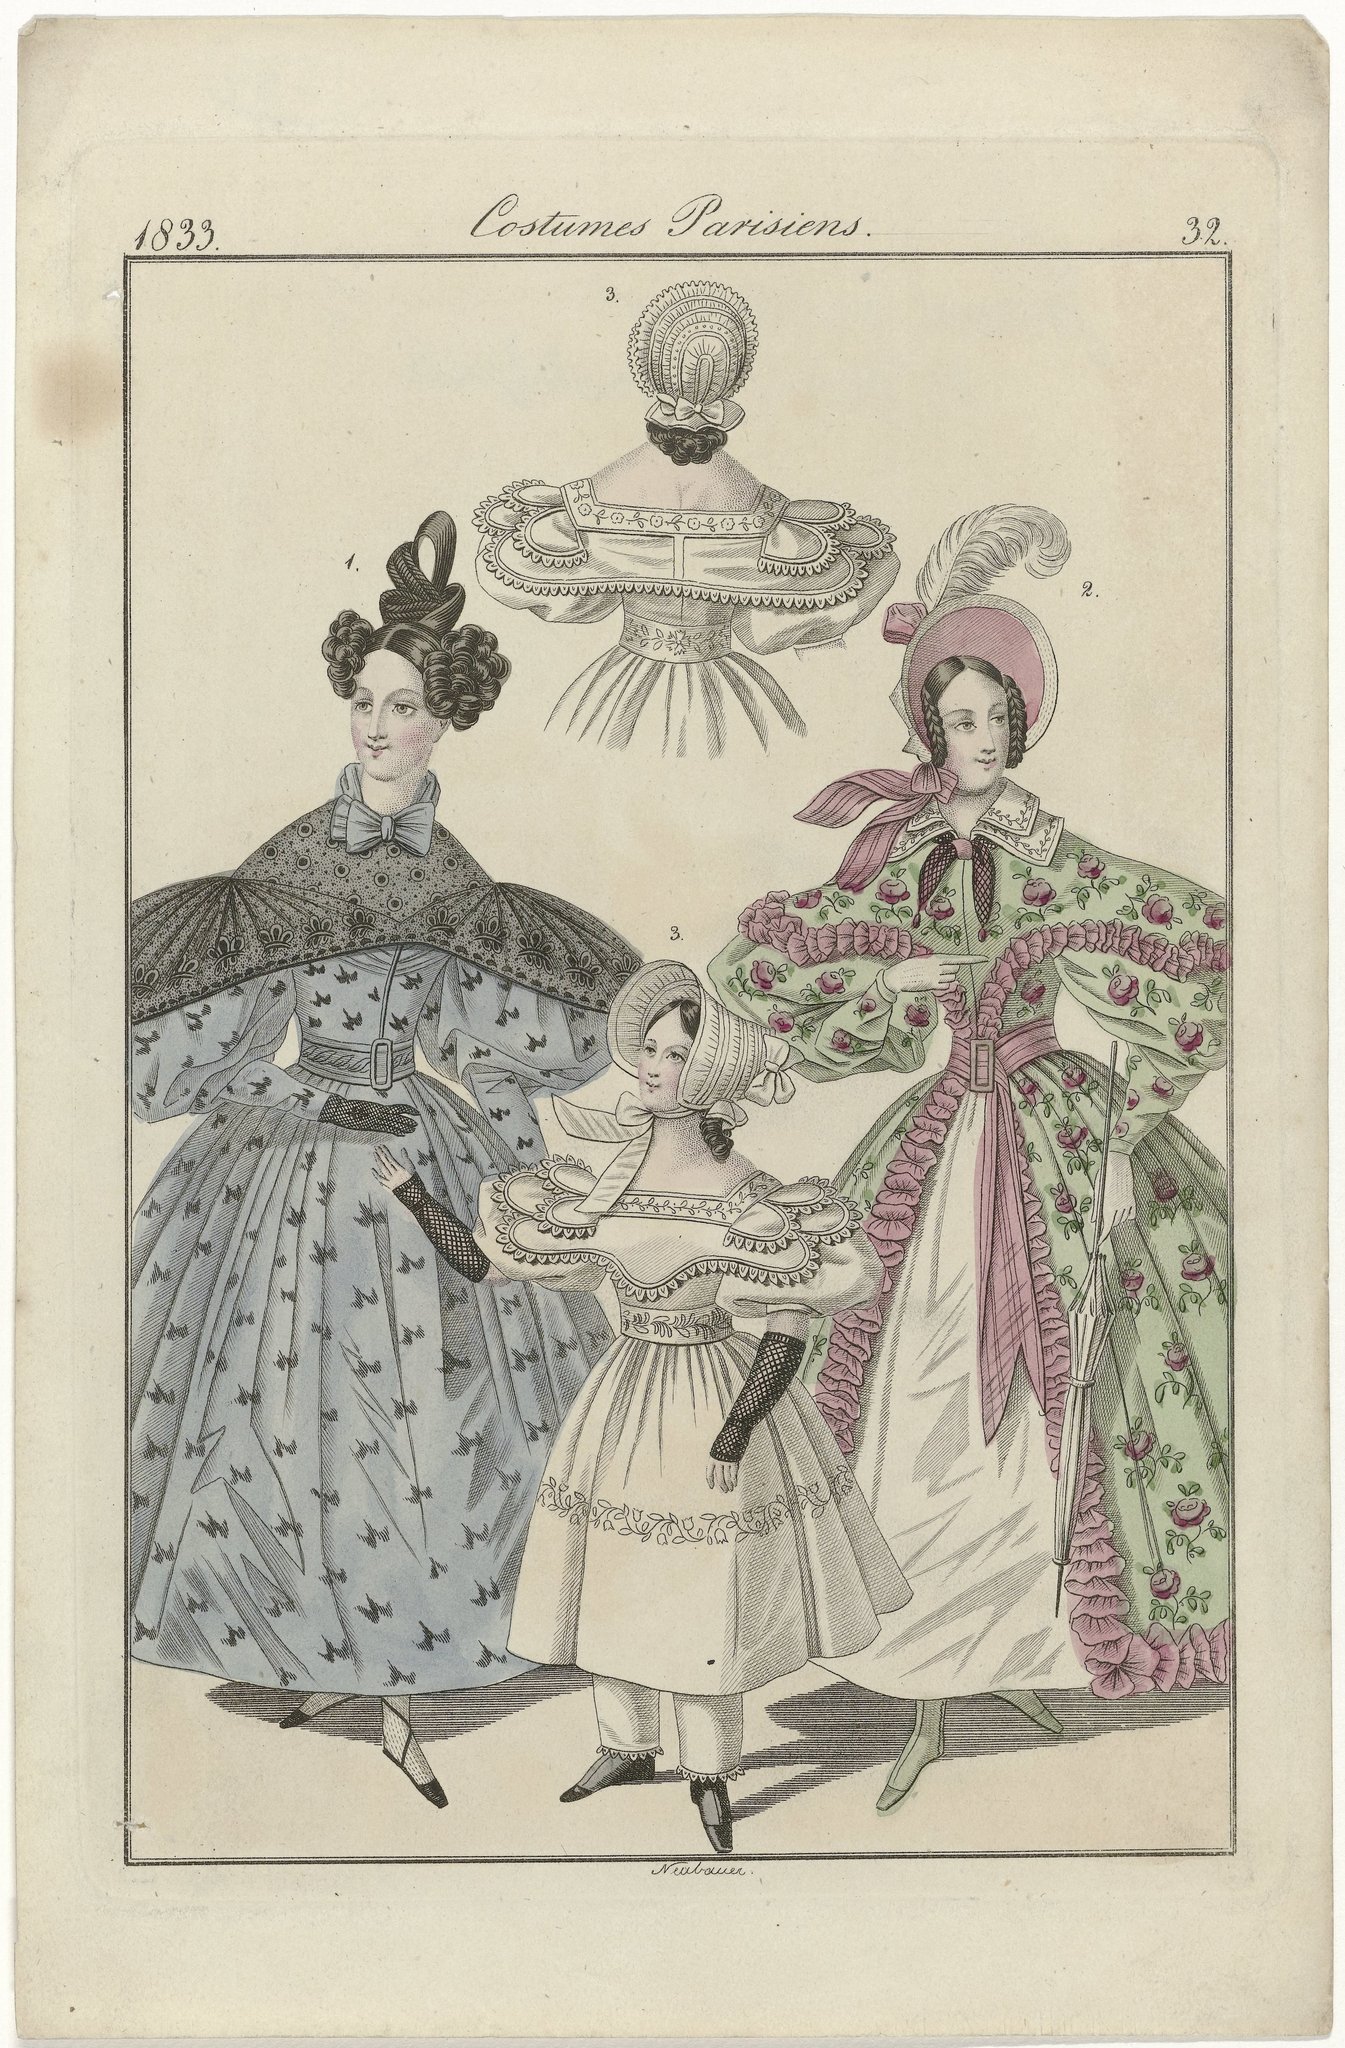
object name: fashion print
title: Journal des Dames et des Modes, Frankfurt 1833, Costumes Parisiens (32)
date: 1833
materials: paper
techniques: engraving, hand coloring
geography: frankfurt am main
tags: clothing for the upper part of the body (+ women's clothes), head-gear: cap (+ girls' clothes), underclothes for the lower part of the body: bloomers (+ girls' clothes), boots (+ girls' clothes), head-gear (capote) (+ girls' clothes), gloves, mittens (mitaines) (+ girls' clothes), lace (+ girls' clothes), fashion plates, head-gear: hat (+ women's clothes), gloves, mittens, etc. (+ women's clothes), dress, gown (+ women's clothes), shoes, sandals, neck-gear ~ clothing (+ women's clothes), dress, gown (+ girls' clothes)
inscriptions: title: ‘Costumes Parisiens’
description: Twee vrouwen, genummerd 1 en 2, in verschillende japonnen. Accessoires: hoed met struisveer, handschoenen, ceintuur, parasol, puntige schoenen met gekruiste banden (cothurnes). Het meisje, nummer 3, is een aangepaste kopie (hier met het hoofd en de rechterarm omhoog) naar Pl. 318, 3 août 1833, La Mode, 1829-1855 : 'capote' van 'gros de naples'. Muts van mousseline en japonnen van geborduurde 'jaconas' versierd met kant uit de winkels van Rome. Prent uit het modetijdschrift Journal des Dames et des Modes (Frankfurt am Main 1798-1848).